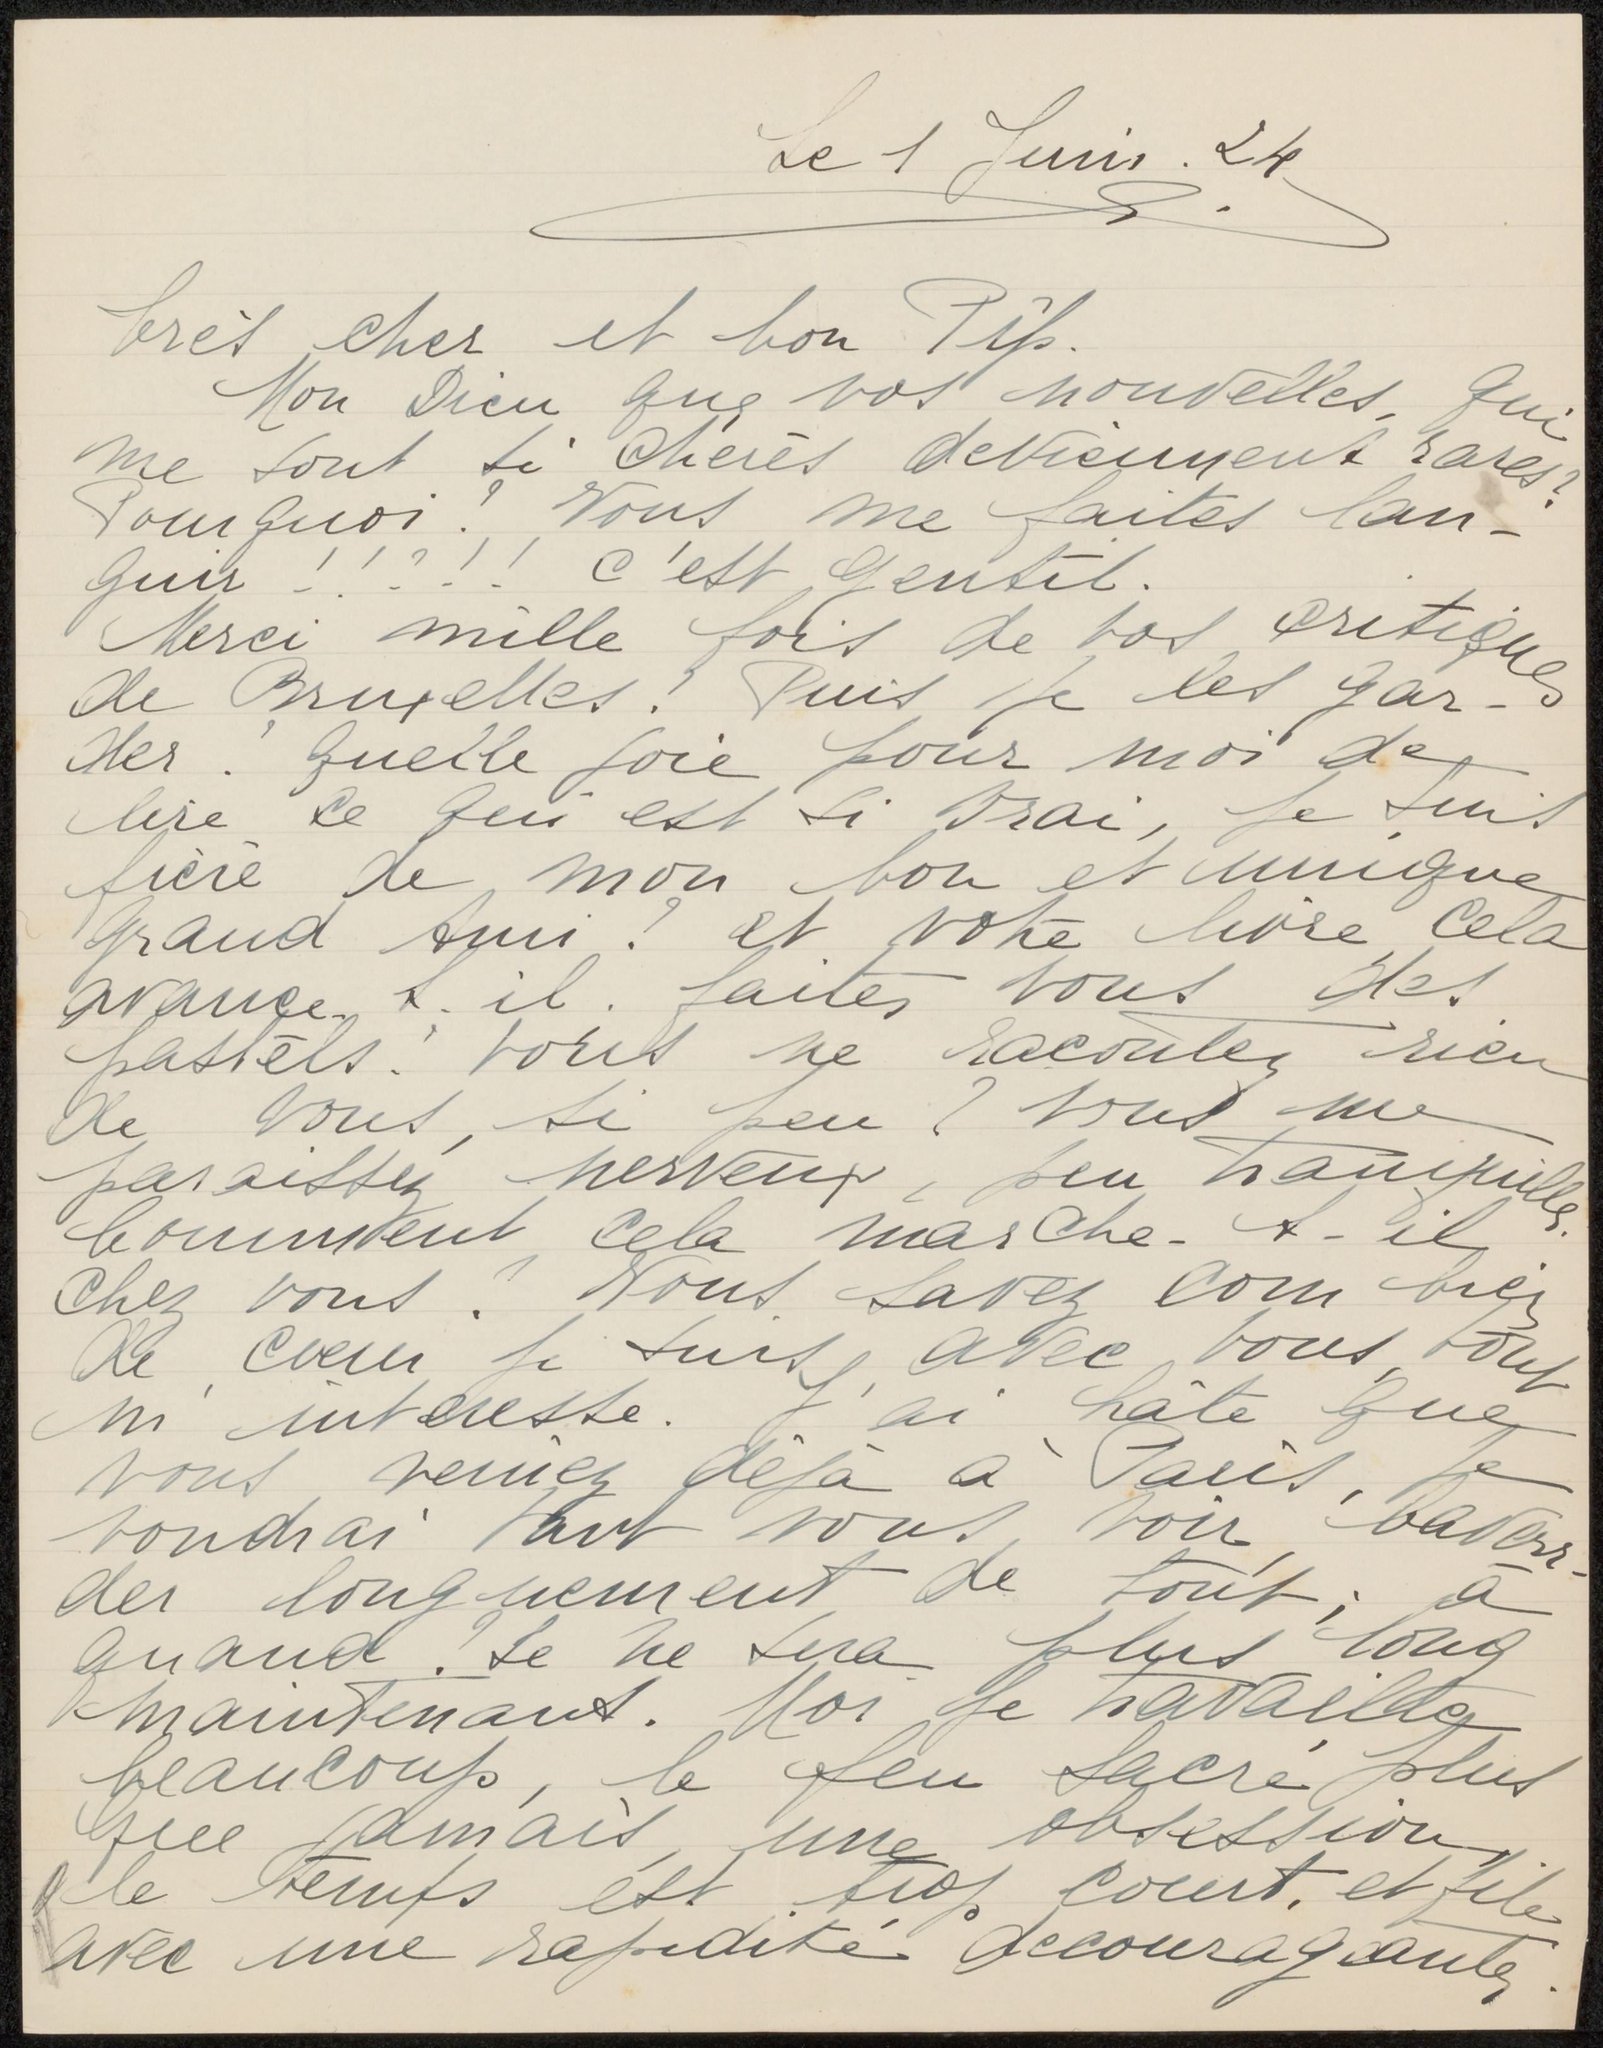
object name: letter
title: Brief aan Philip Zilcken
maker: rose imel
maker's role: draughtsman, painter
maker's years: 1901-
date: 1924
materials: ink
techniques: pen, writing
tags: painter, draughtsman, philip zilcken, criticizing and discussing art, art criticism, brussels, paris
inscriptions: collector's mark: ‘RPK’